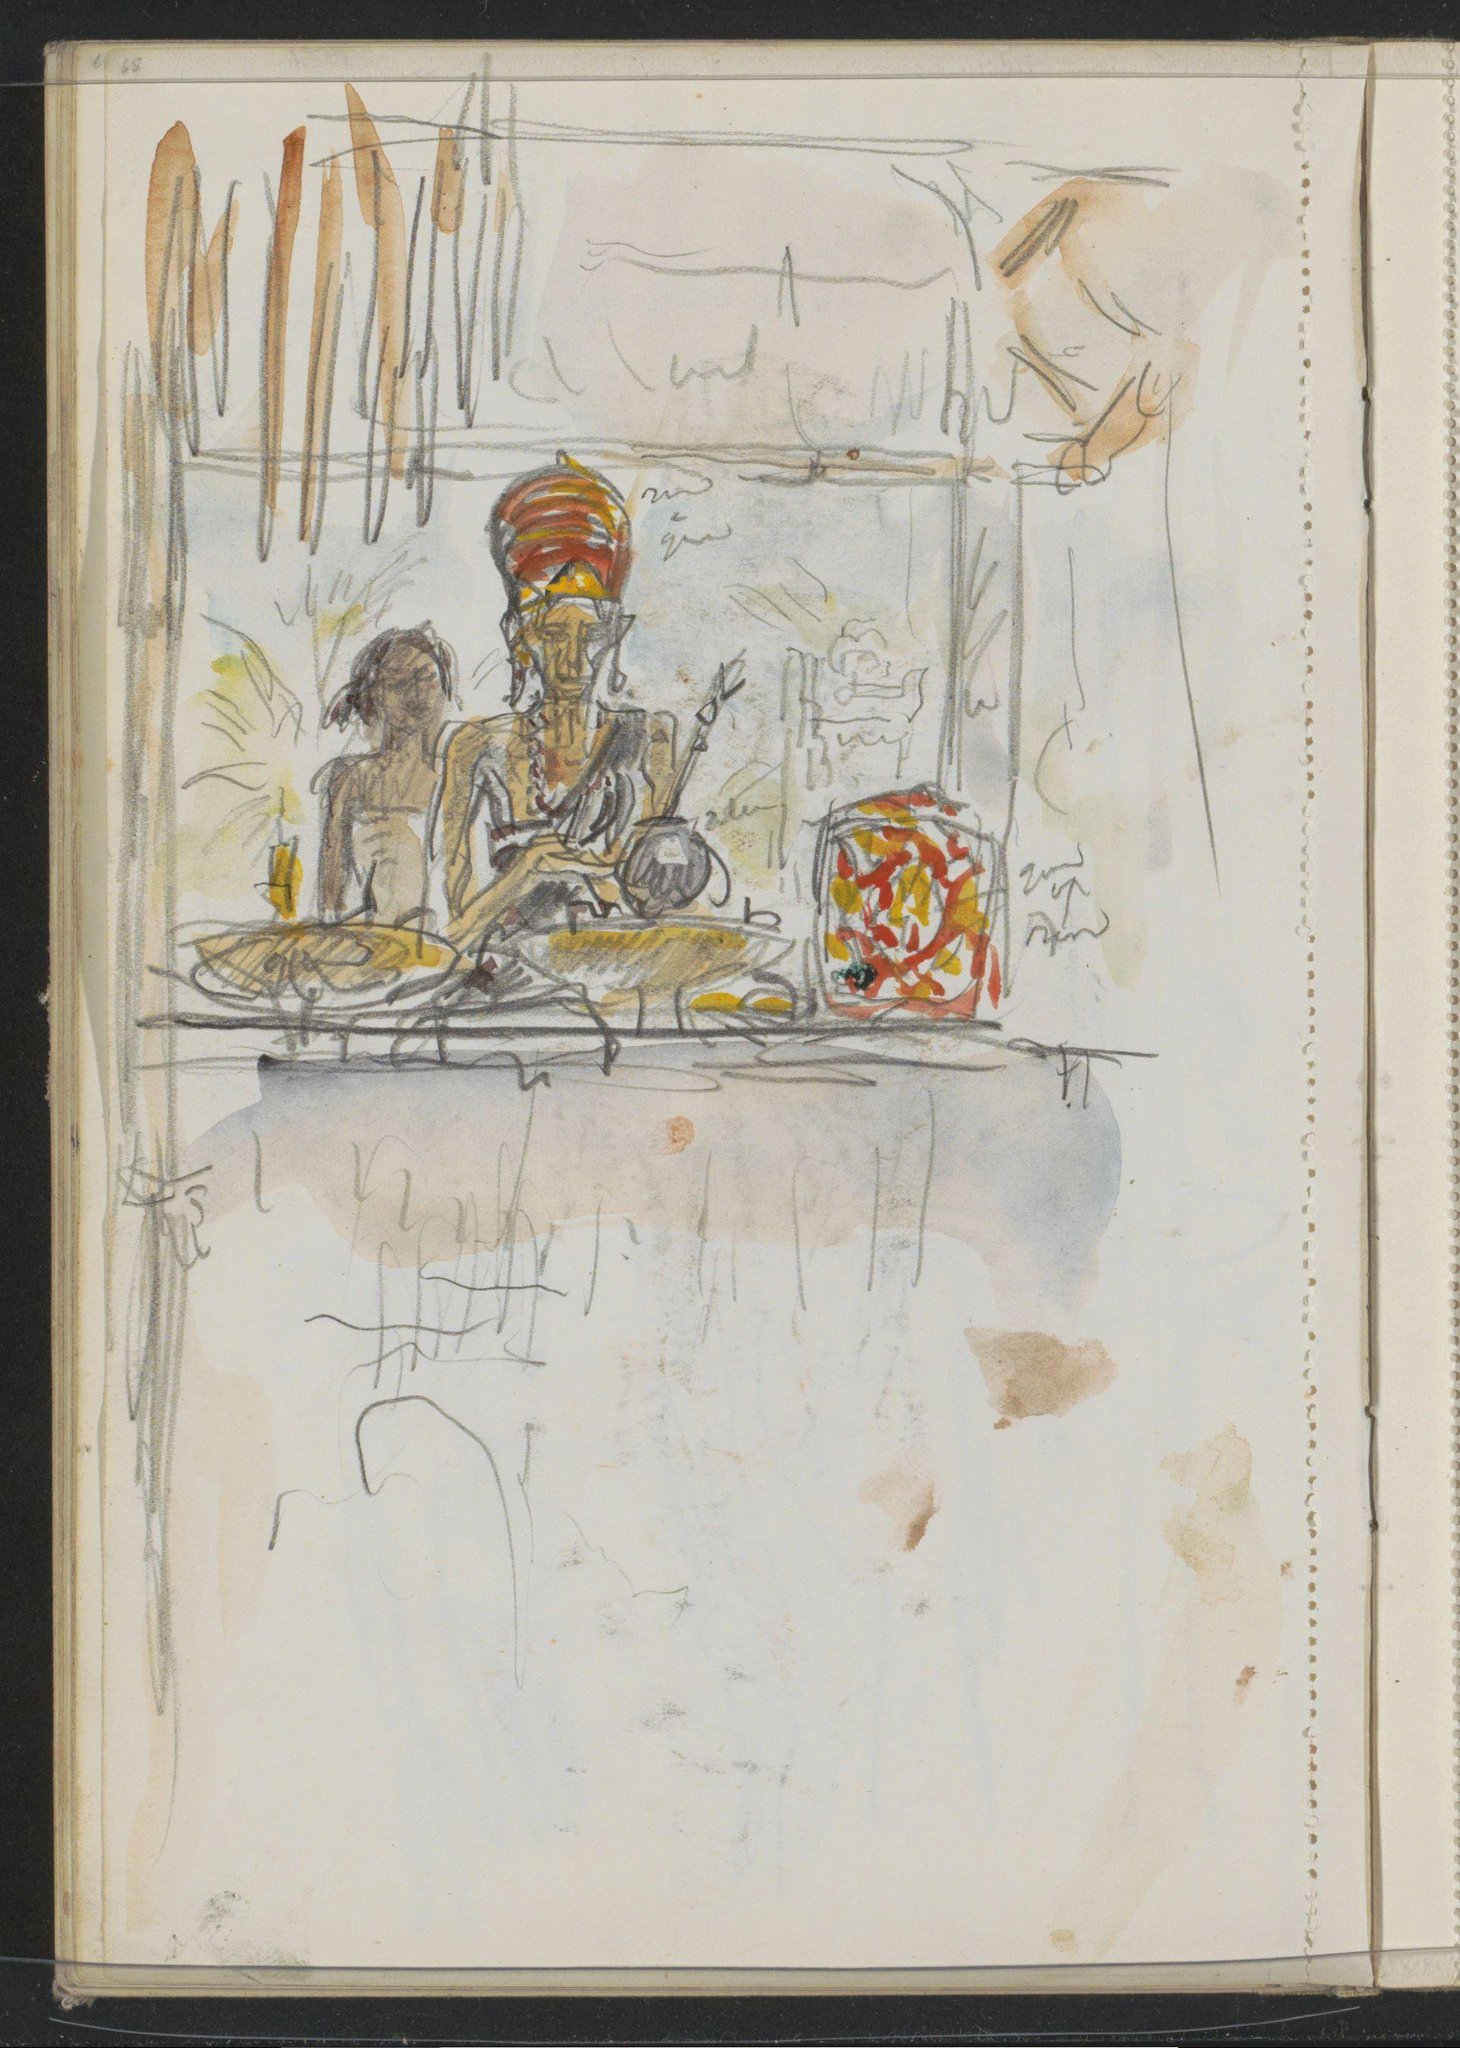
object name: sketchbook leaf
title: Offeraltaar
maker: marius bauer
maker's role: draughtsman, print maker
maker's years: 1867-1932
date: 1925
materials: paper, pencil, watercolor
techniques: brush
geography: indonesia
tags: altar ~ hinduism, buddhism, jainism, sacrifice ~ non-christian religions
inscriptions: kleurnotitie, handgeschreven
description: Pagina 68 uit een schetsboek met 74 bladen.